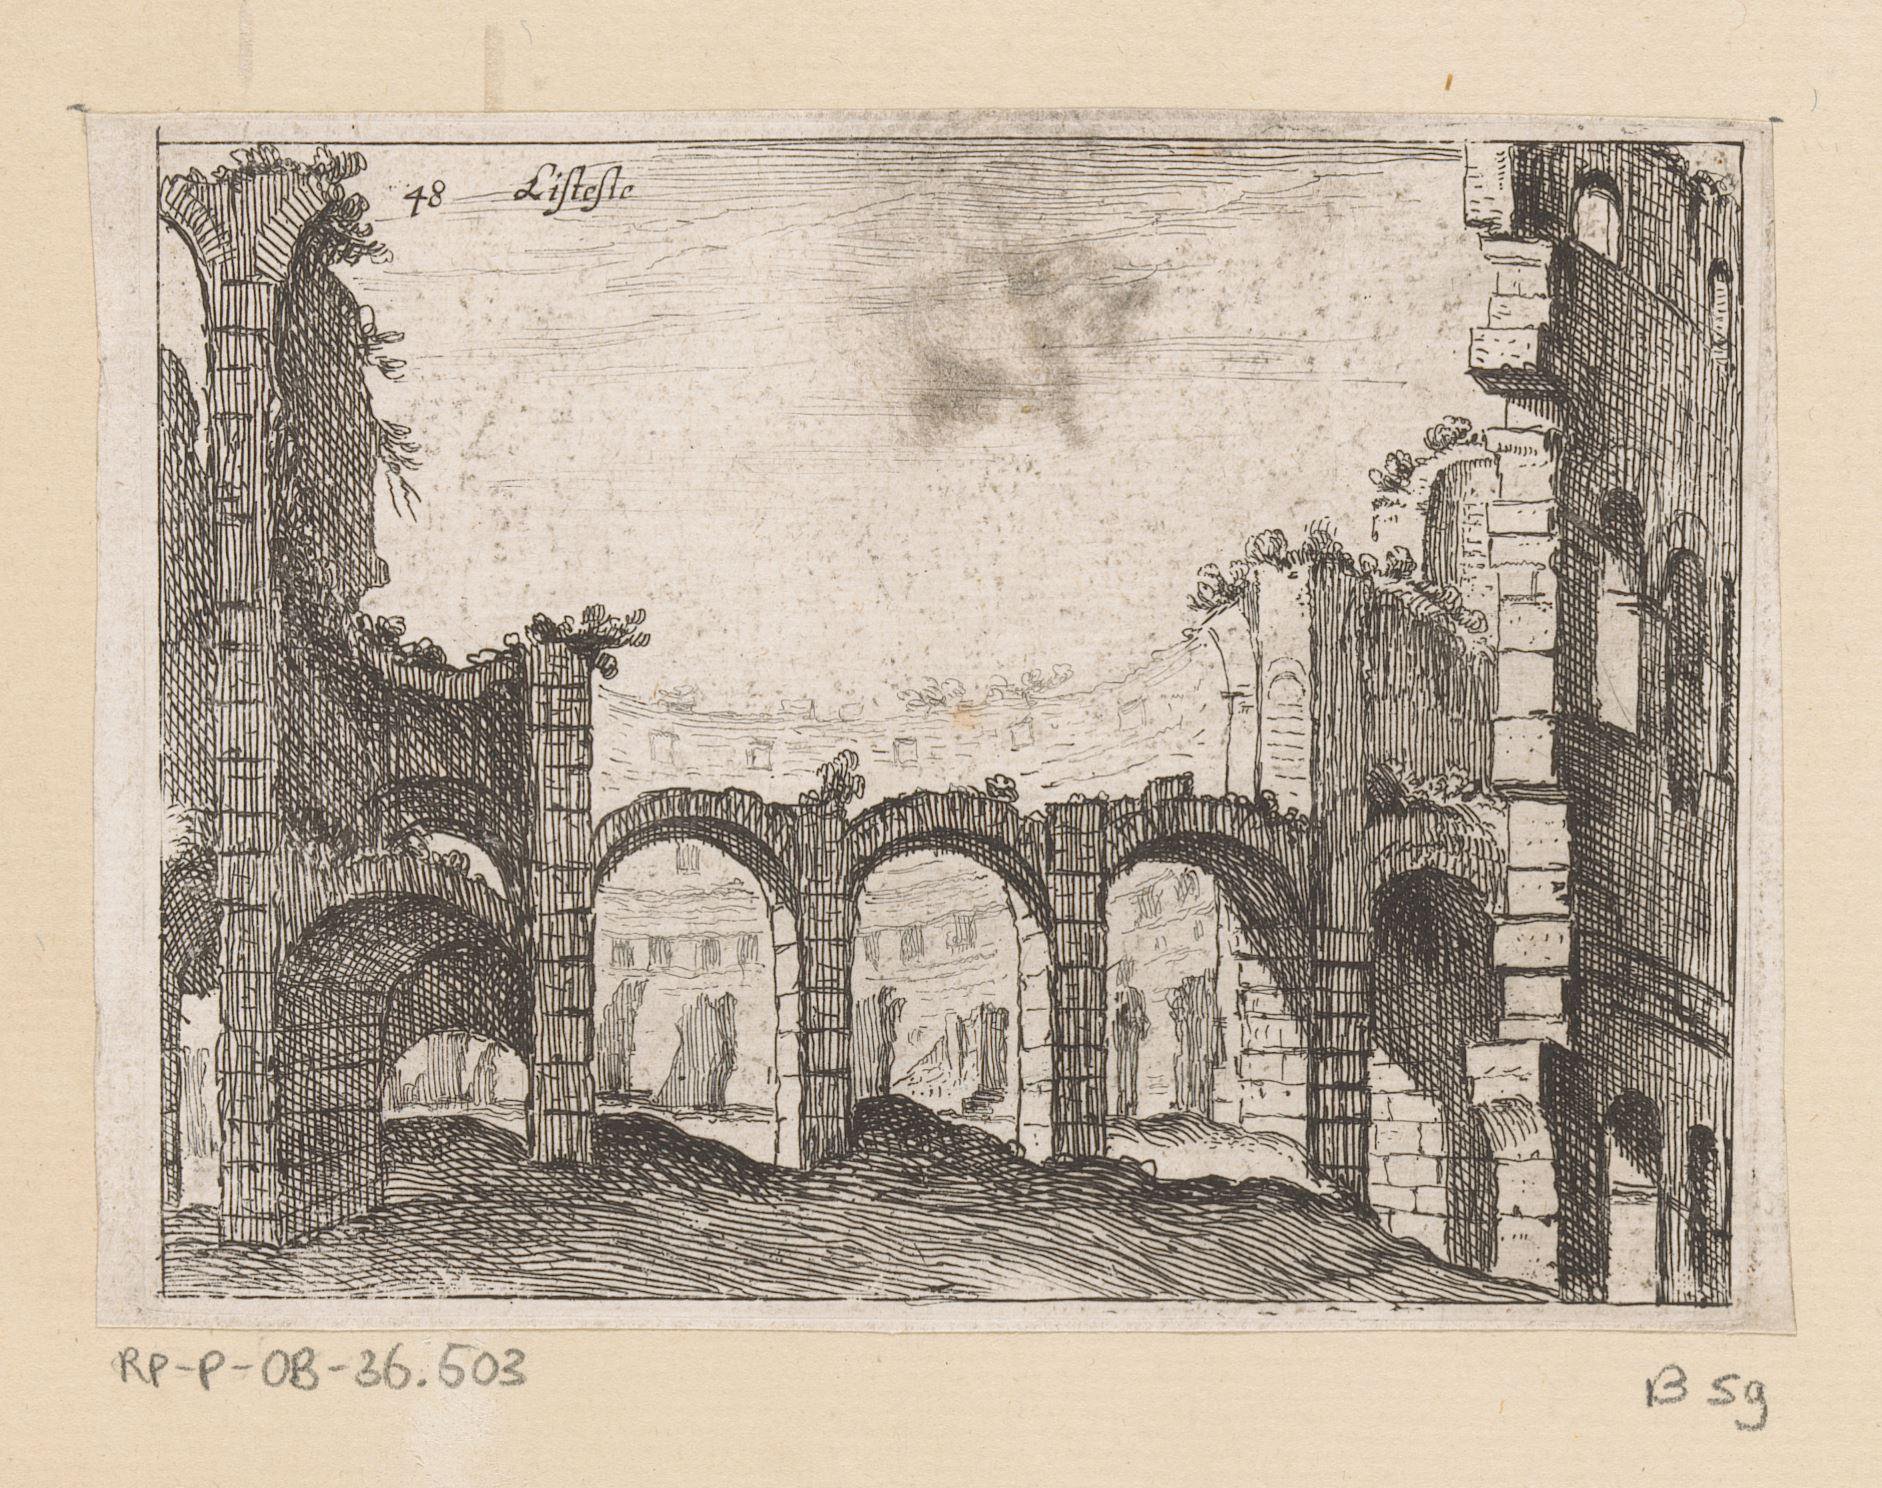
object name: print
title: Gezichten op Rome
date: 1629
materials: paper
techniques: etching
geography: italy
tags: landscape with ruins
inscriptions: collector's mark: Lugt 2228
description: Deze prent maakt deel uit van een reeks van 52 prenten.